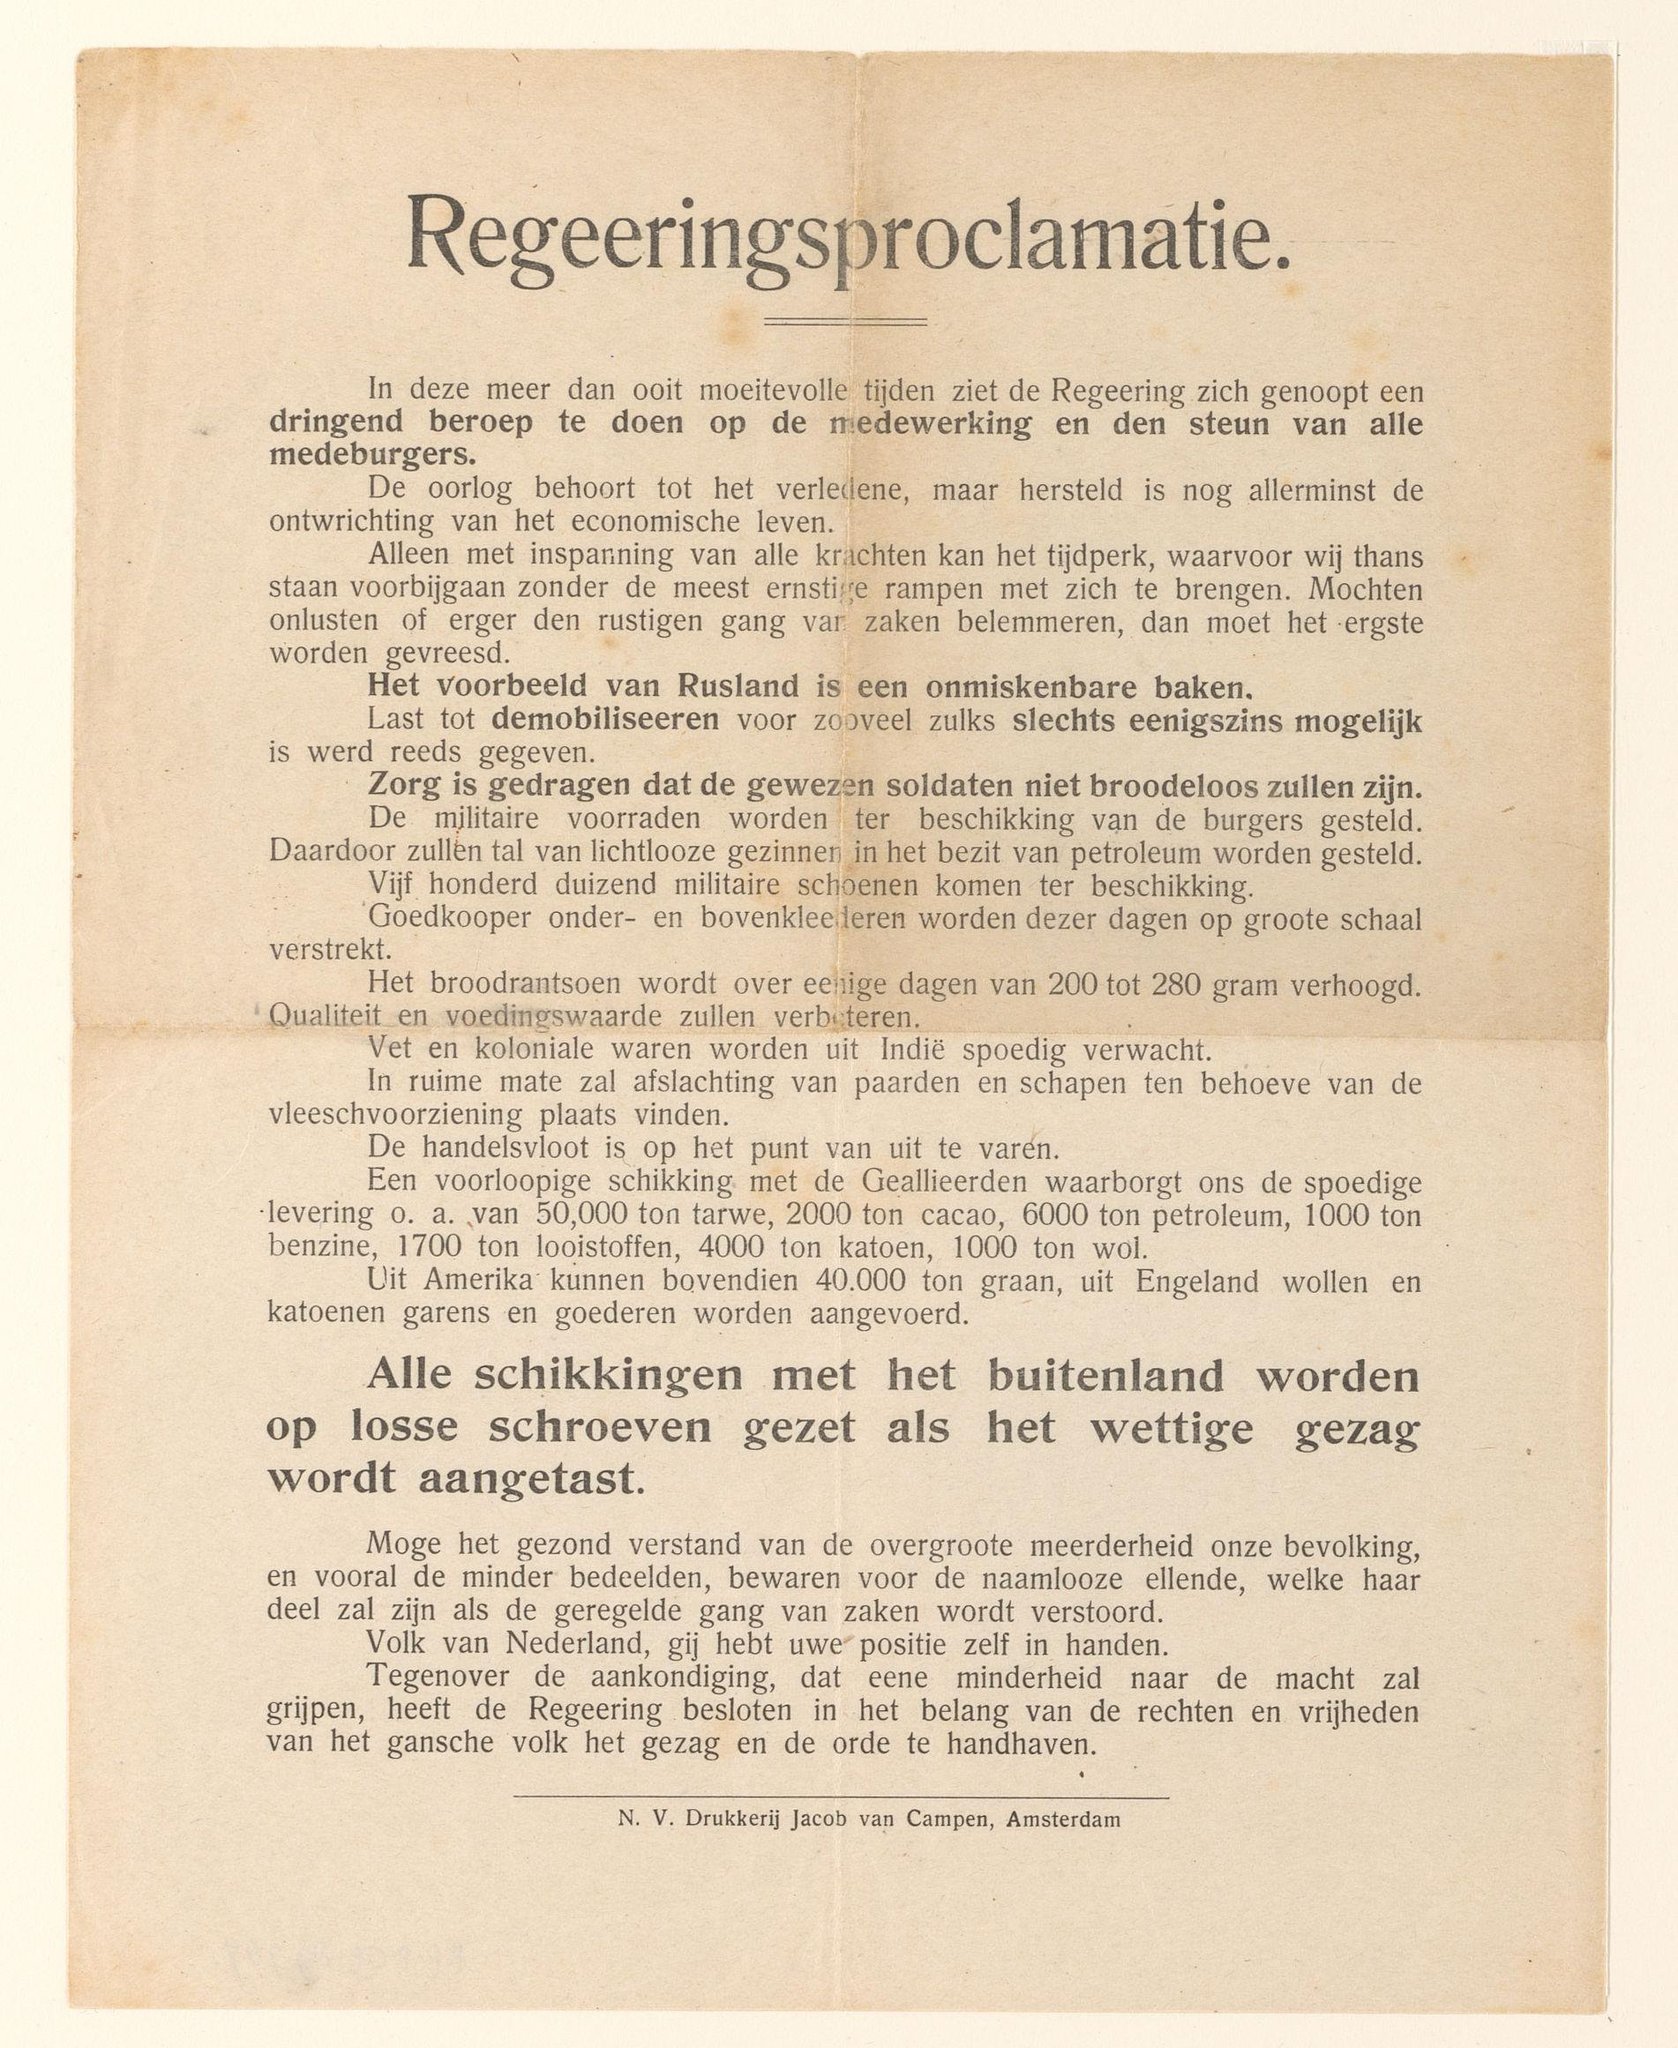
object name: text sheet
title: Regeeringsproclamatie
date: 1918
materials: paper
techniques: letterpress printing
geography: amsterdam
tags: netherlands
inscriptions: collector's mark: Lugt 2228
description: Proclamatie door de regering bij de demobilisatie van het Nederlandse leger na afloop van de Eerste Wereldoorlog in 1918. Tekstblad bedrukt op één zijde.